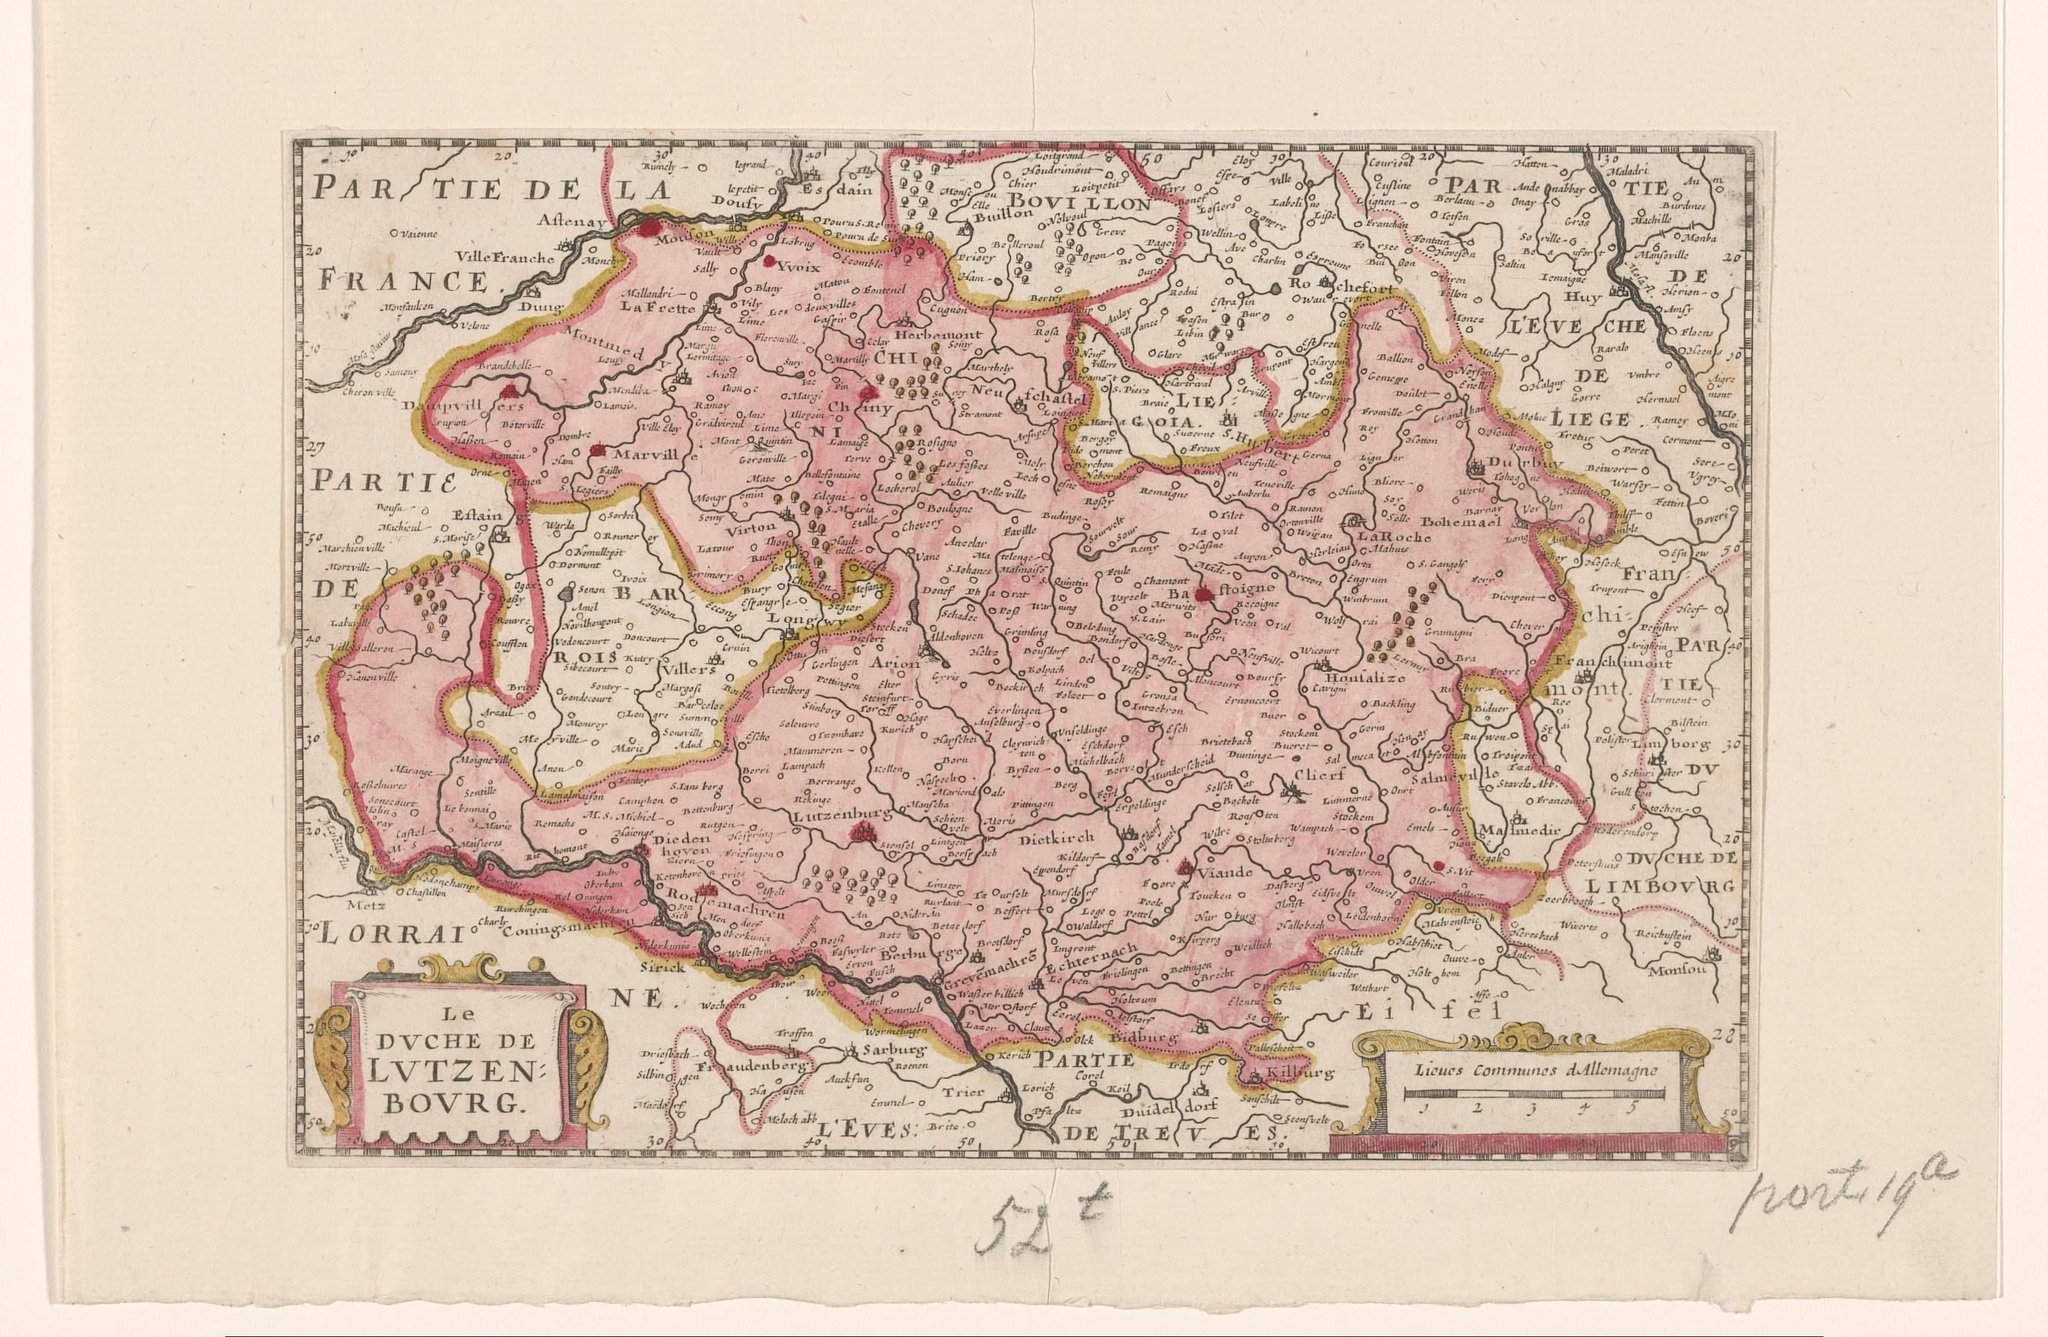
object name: print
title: Kaart van het hertogdom Luxemburg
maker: Anonymous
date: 1635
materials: paper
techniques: engraving, etching, hand coloring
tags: maps of separate countries or regions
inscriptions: collector's mark: Lugt 2228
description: Deze staat van prent ook gebruikt in: De vyerighe colom klaer vertoonende in vyftich onderscheydene curieuse caarten de XVII. Nederlantsche Provincien (…). Amsterdam: Jacob Aertsz Colom (I), s.a. [ca. 1660]. En in latere uitgaven met de platen van deze publicatie, uitgegeven door Pieter van Alphen (1691) en Pieter van der Slaart (1696). Eerdere staat van prent (zonder '9' rechtsonder) ook gebruikt in eerdere drukken van deze publicatie.